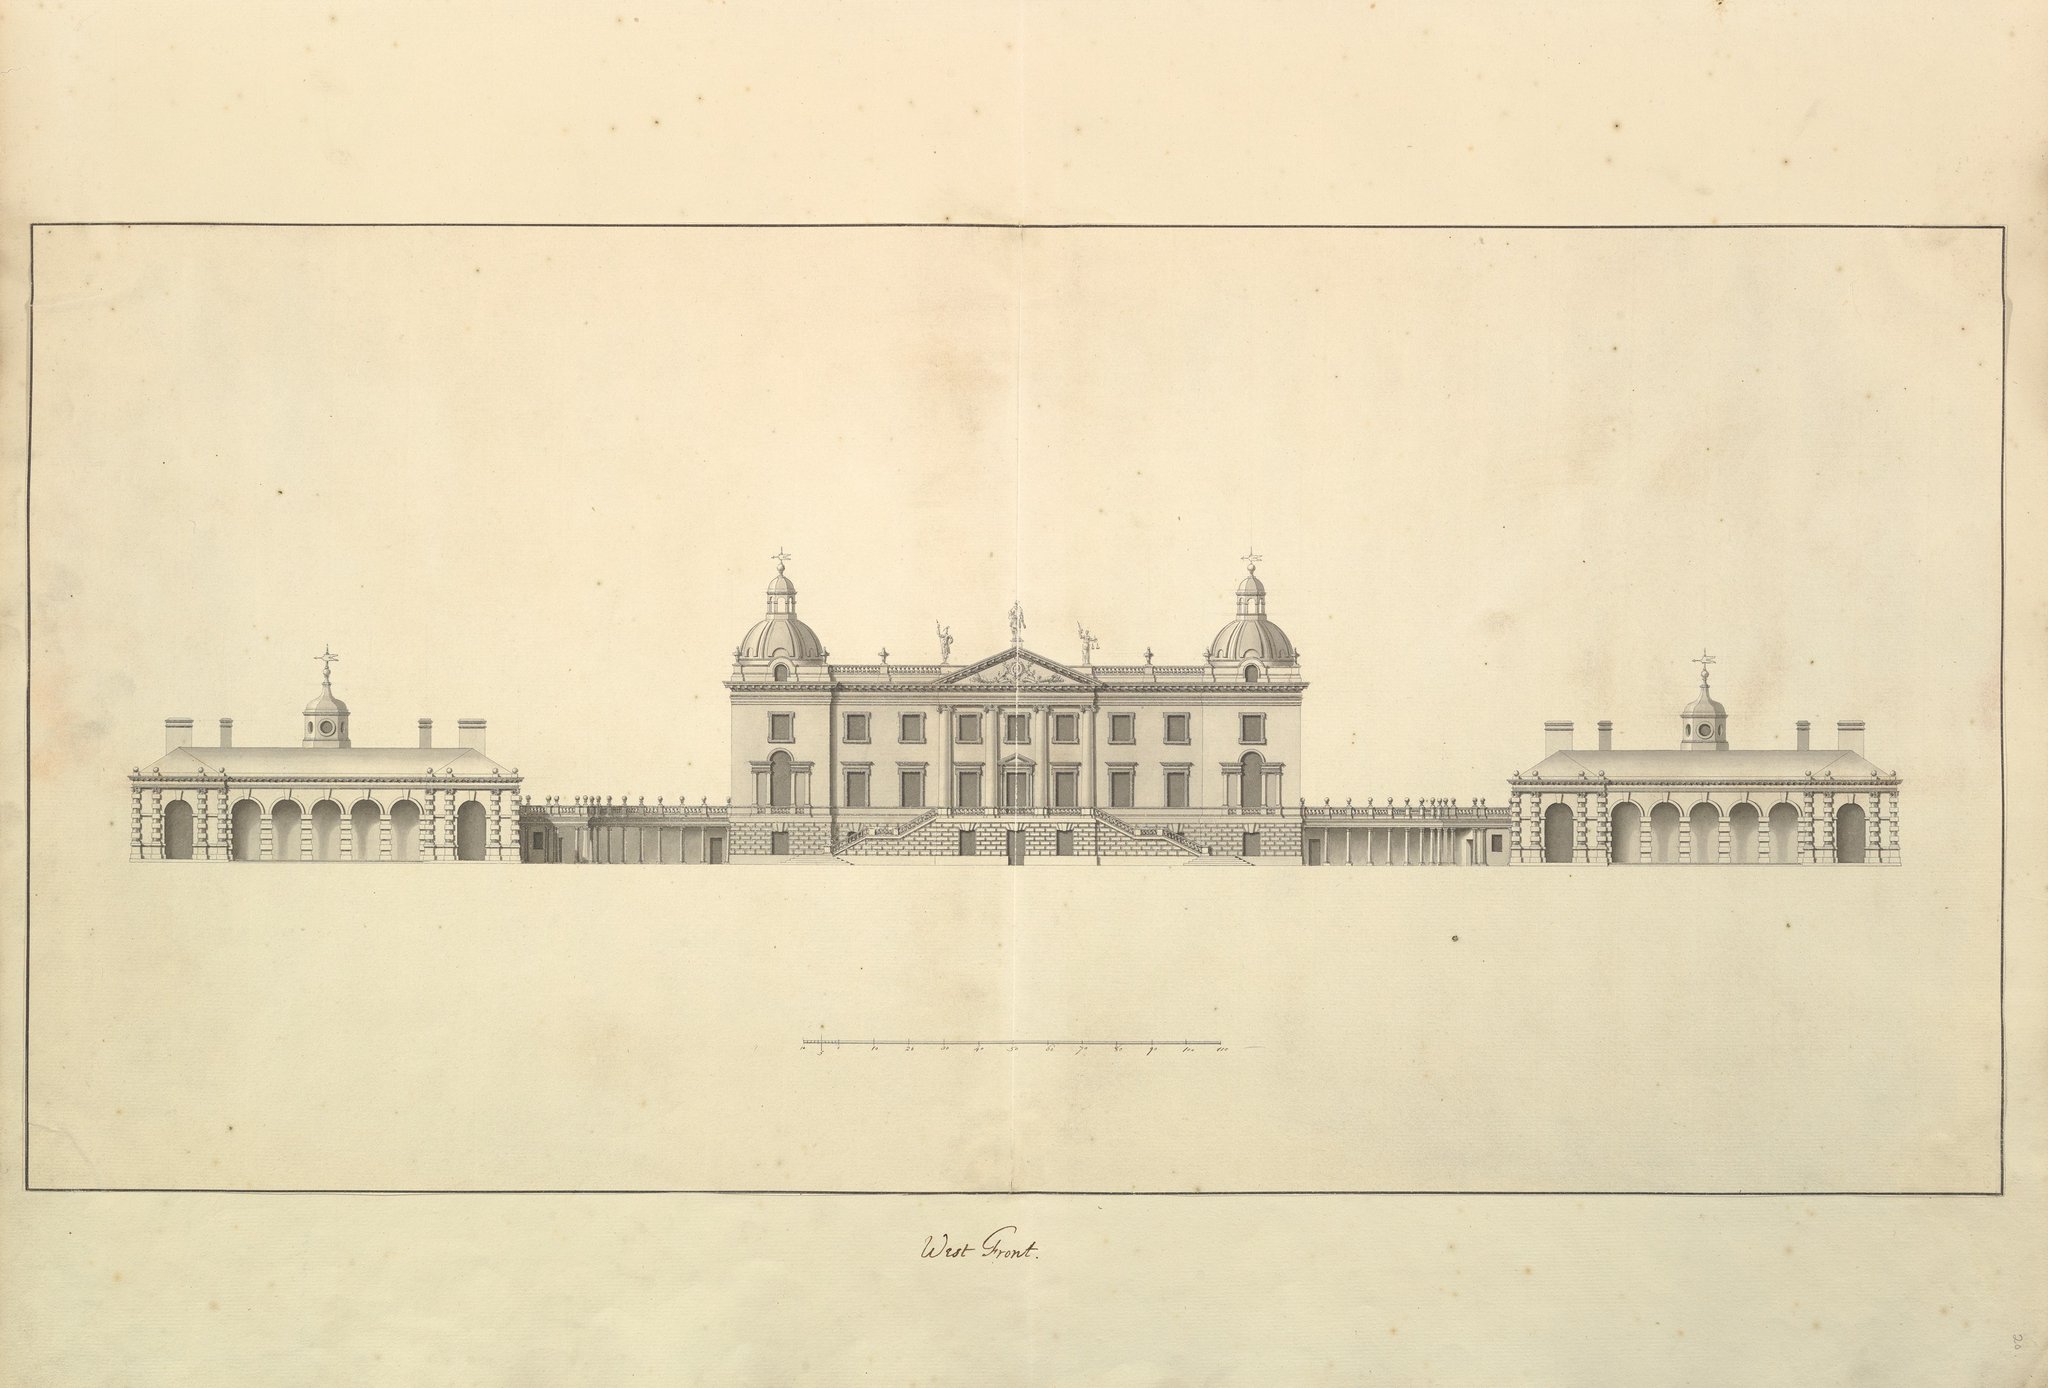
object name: drawing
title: The West Front of Houghton Hall, Norfolk, Elevation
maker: isaac ware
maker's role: artist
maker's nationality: british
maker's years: 1704-1766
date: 1735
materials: ink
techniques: pen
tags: buildings